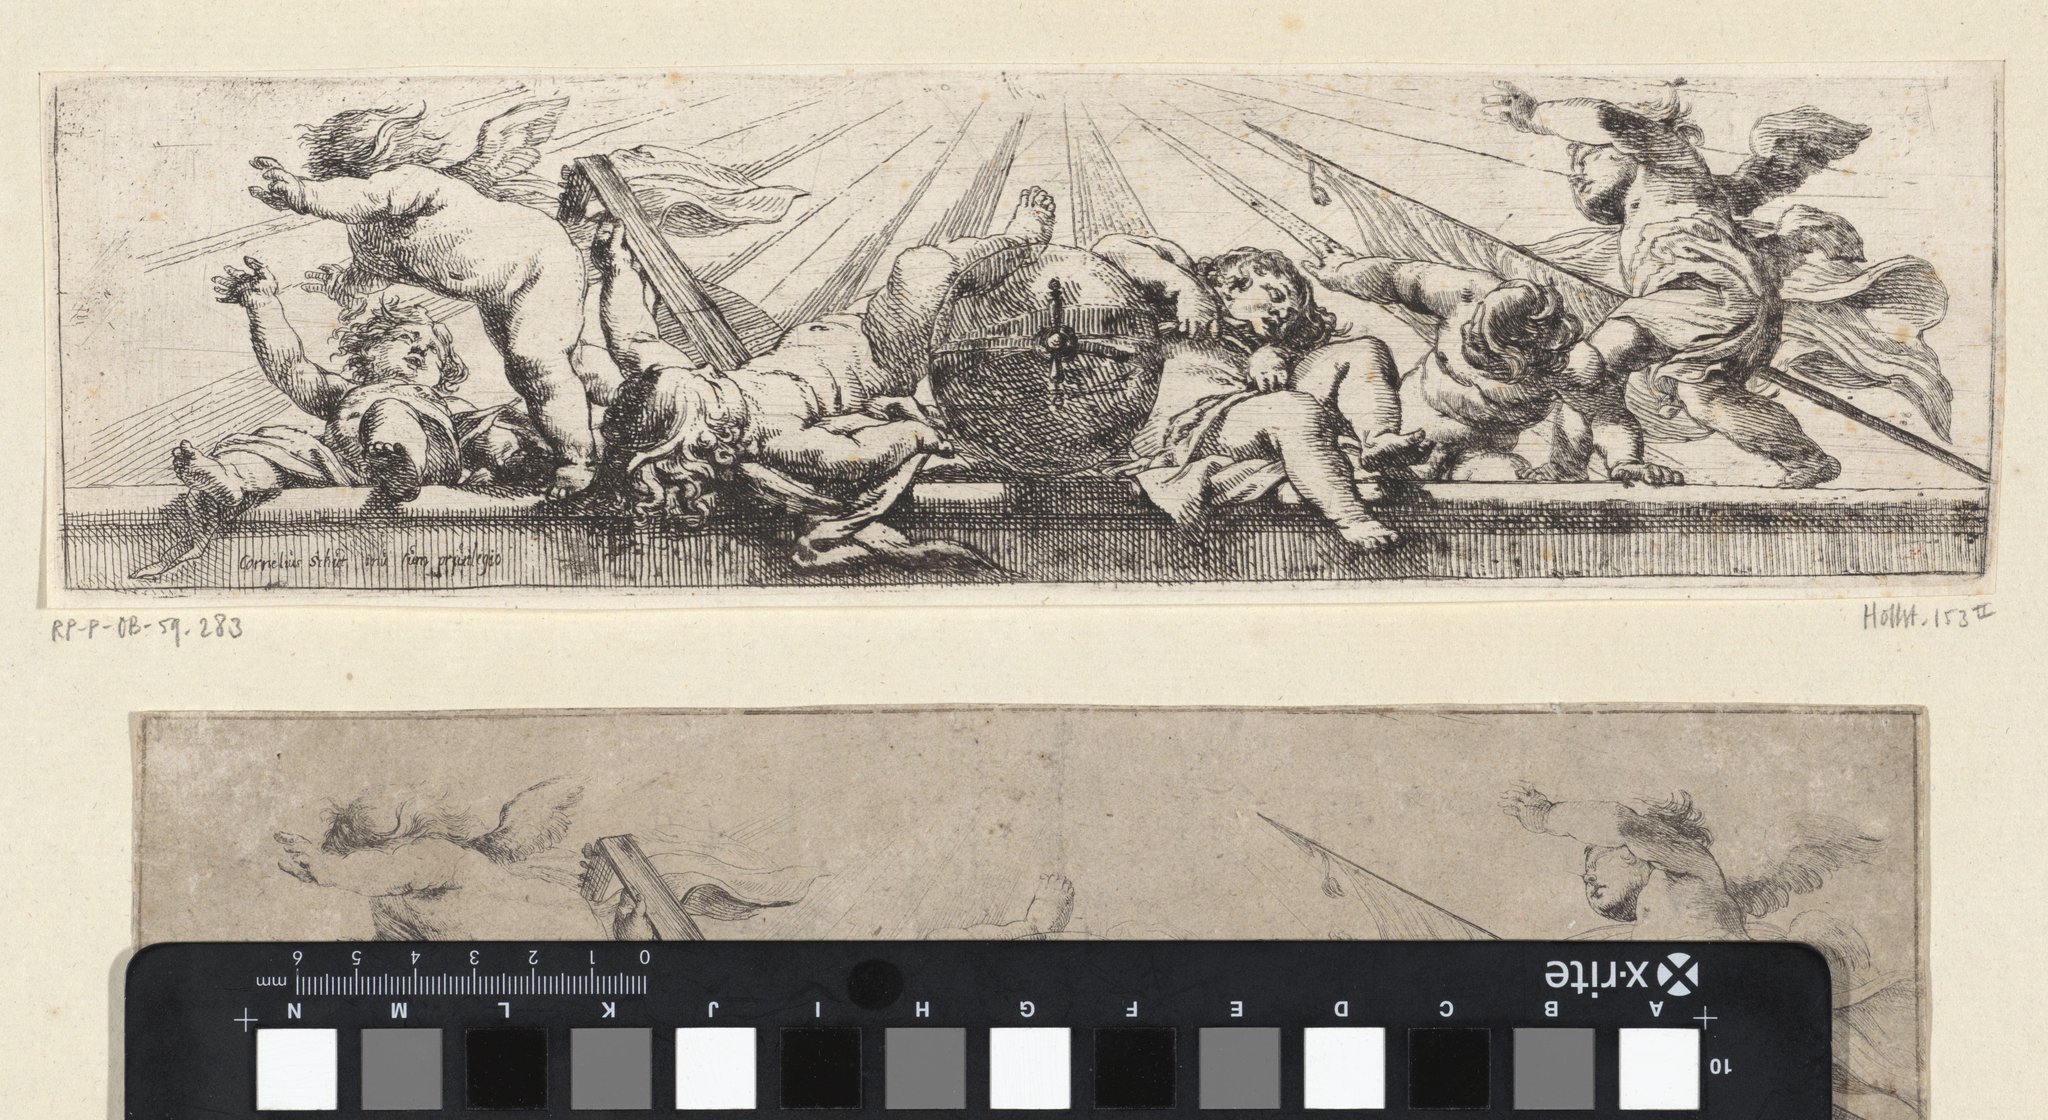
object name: print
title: Fries met zes putti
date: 1618-1655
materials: paper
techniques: etching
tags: flags (~ signalling), globe, cupids: 'amores', 'amoretti', 'putti'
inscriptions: collector's mark: Lugt 240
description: Fries met zes putti rondom een globe. Een van de putti's draagt een vlag.